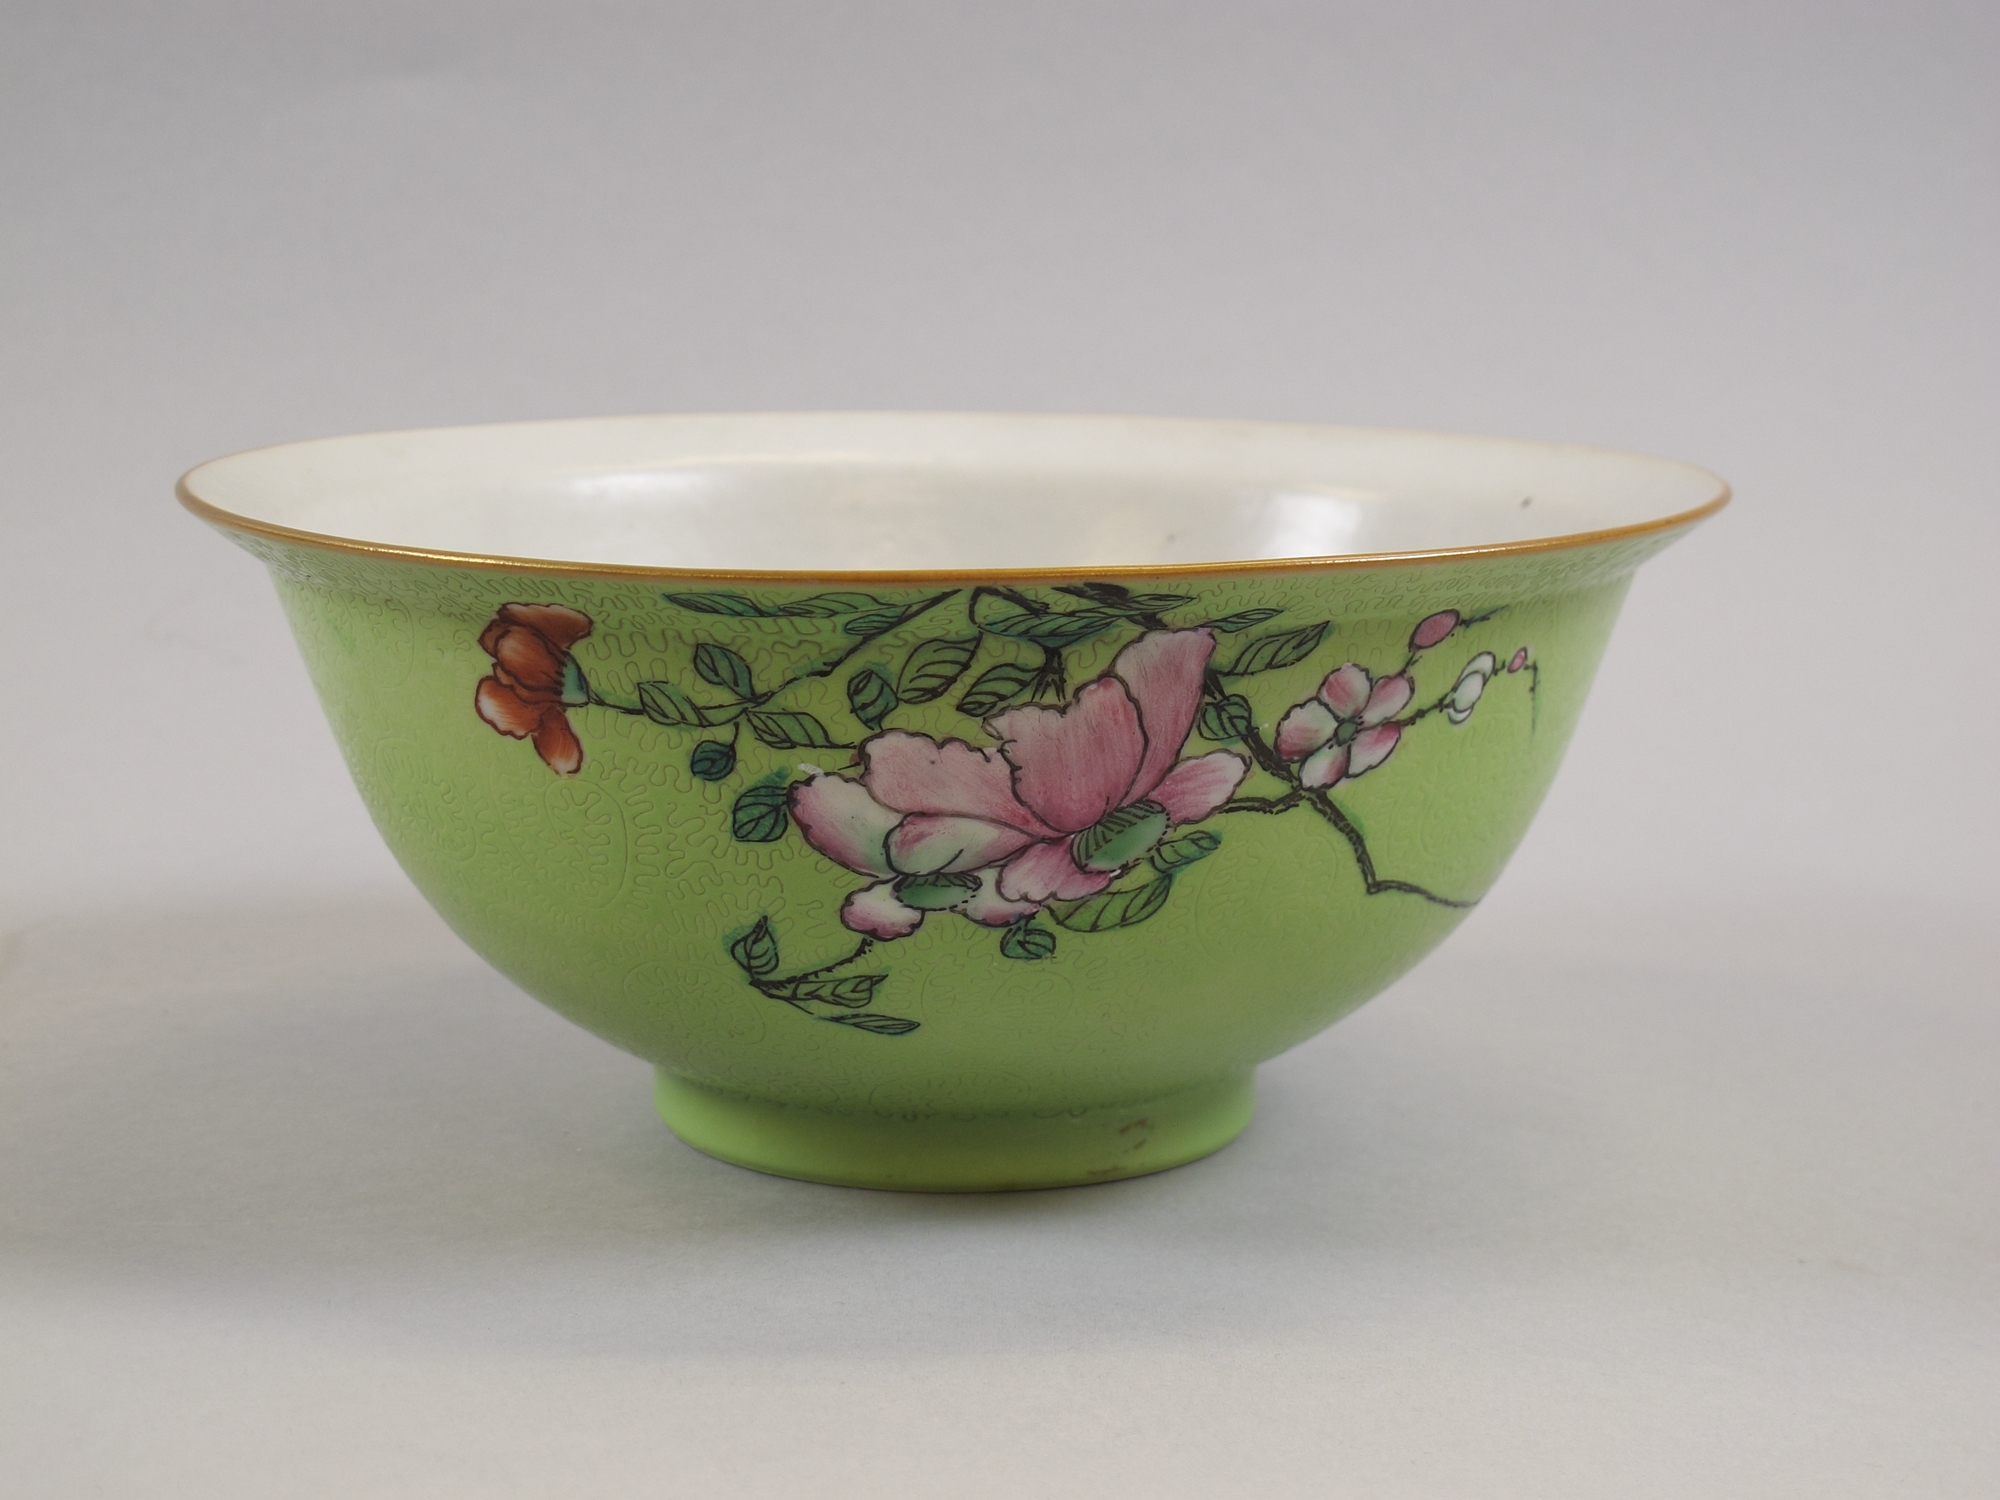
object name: vase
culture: chinese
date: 1801-1850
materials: enamel, porcelain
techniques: engraving, overglaze, painting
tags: flowers,leaves